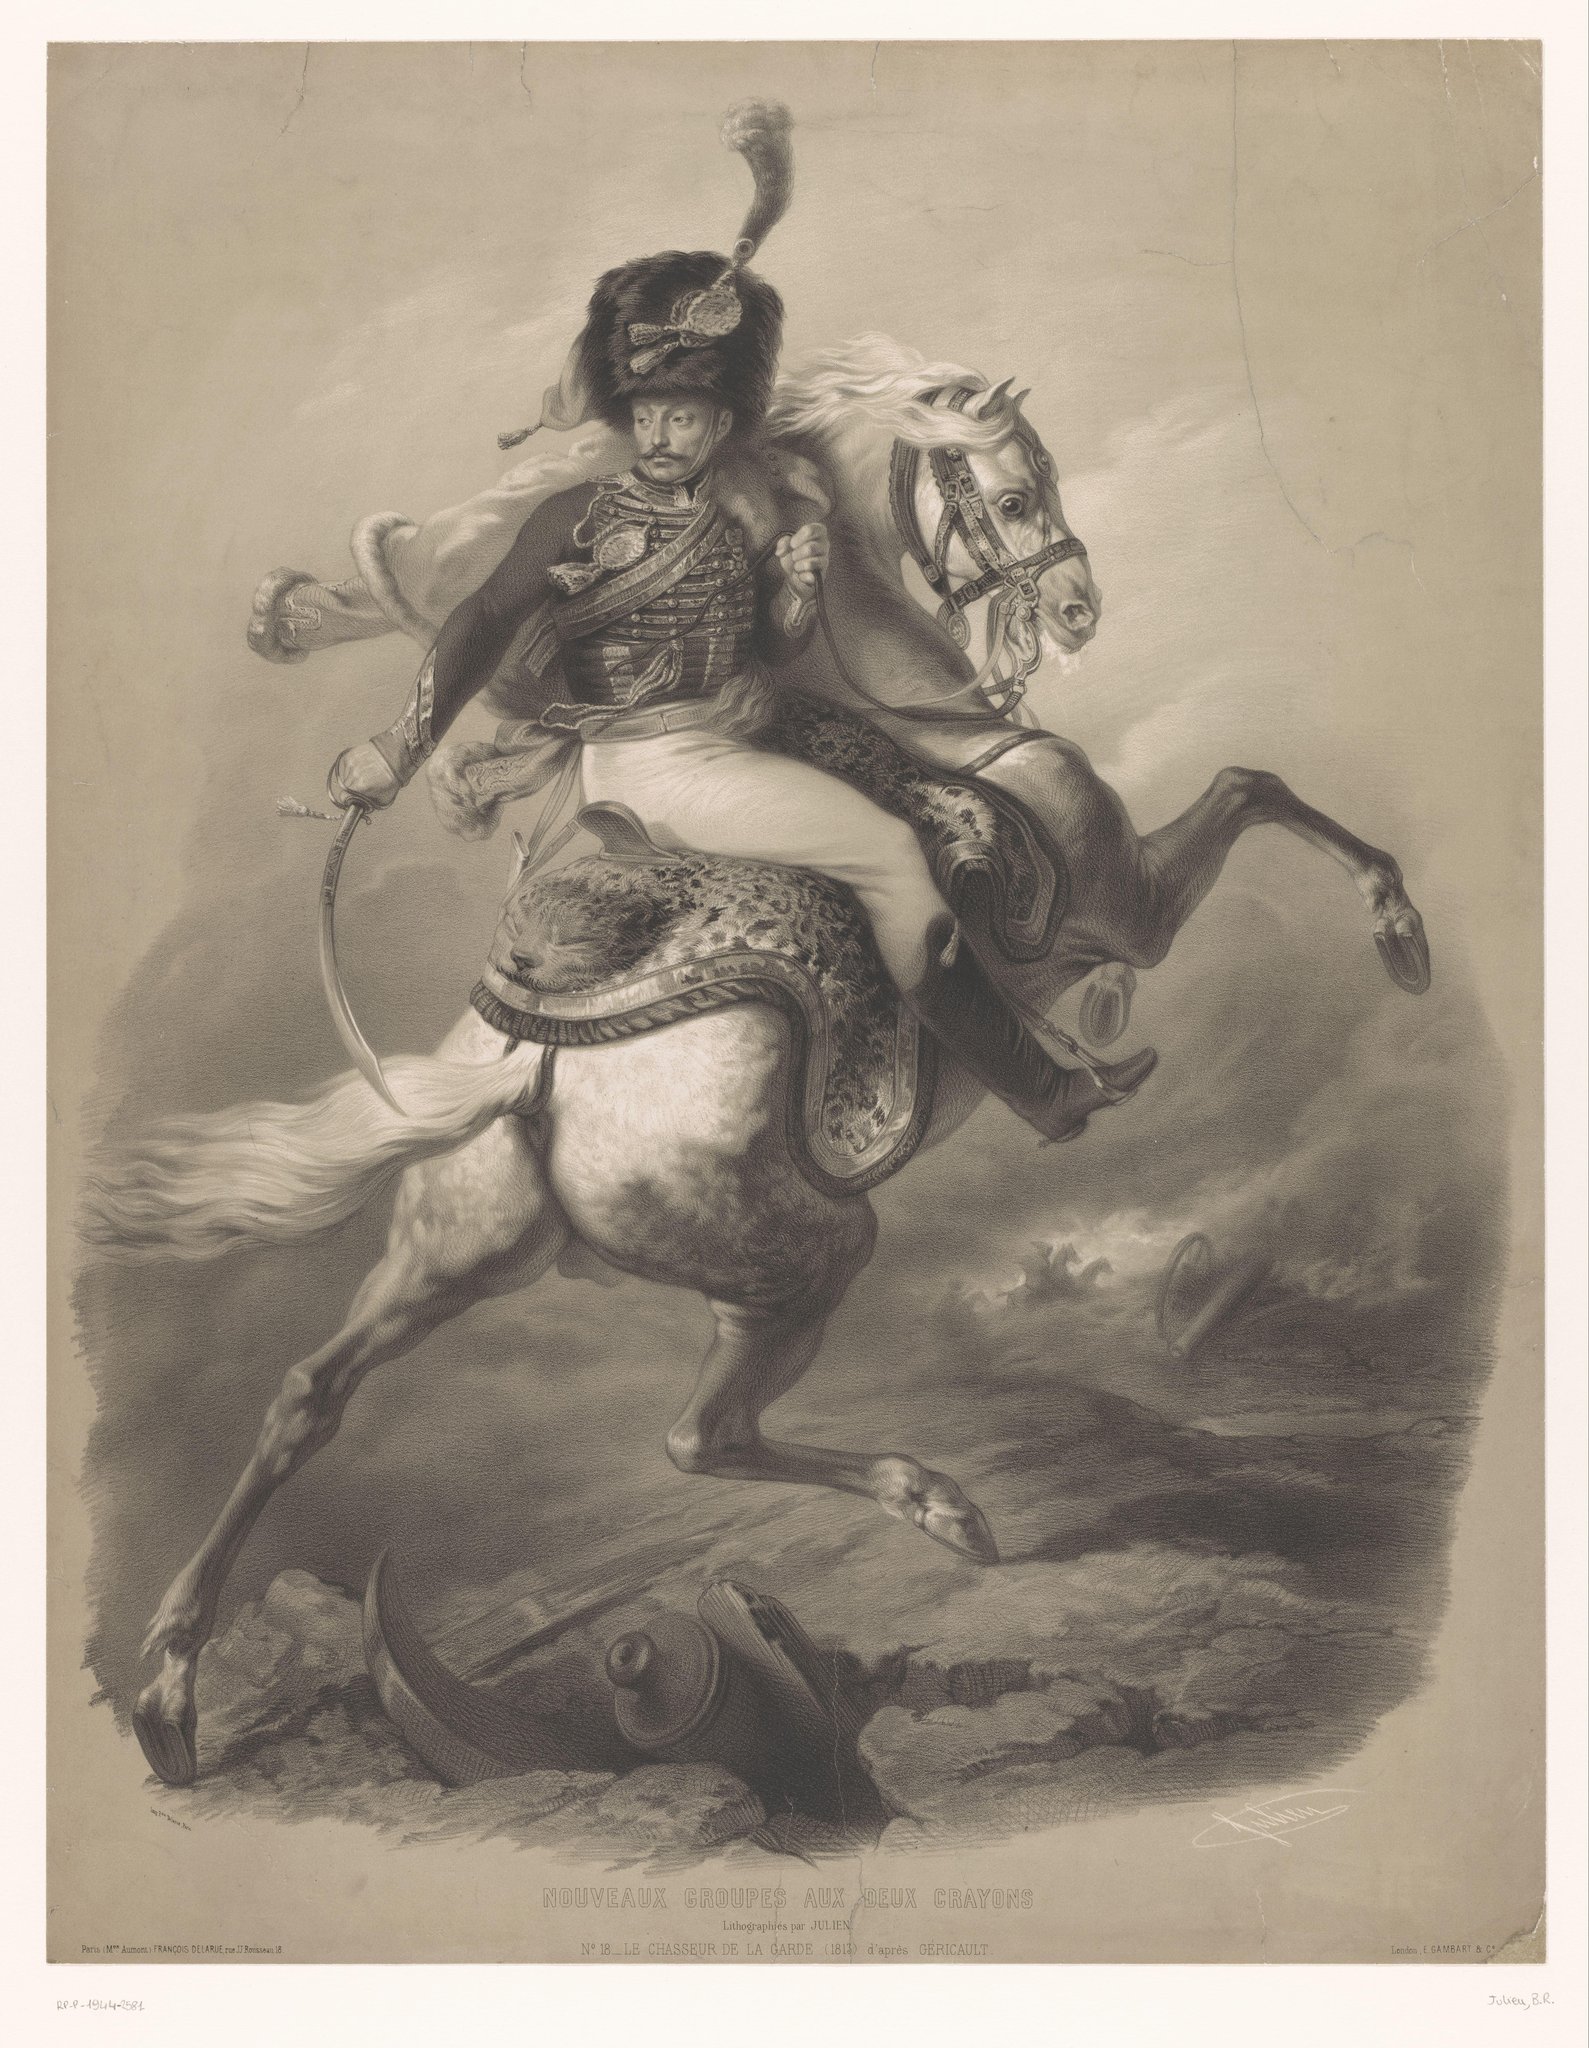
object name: print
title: Nouveaux groupes aux deux crayons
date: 1851-1870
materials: paper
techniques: tone lithography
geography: paris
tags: riding a horse, ass, or mule; rider, horseman, warfare; military affairs (+ cavalry, horsemen), head-gear: cap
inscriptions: collector's mark: Lugt 2228